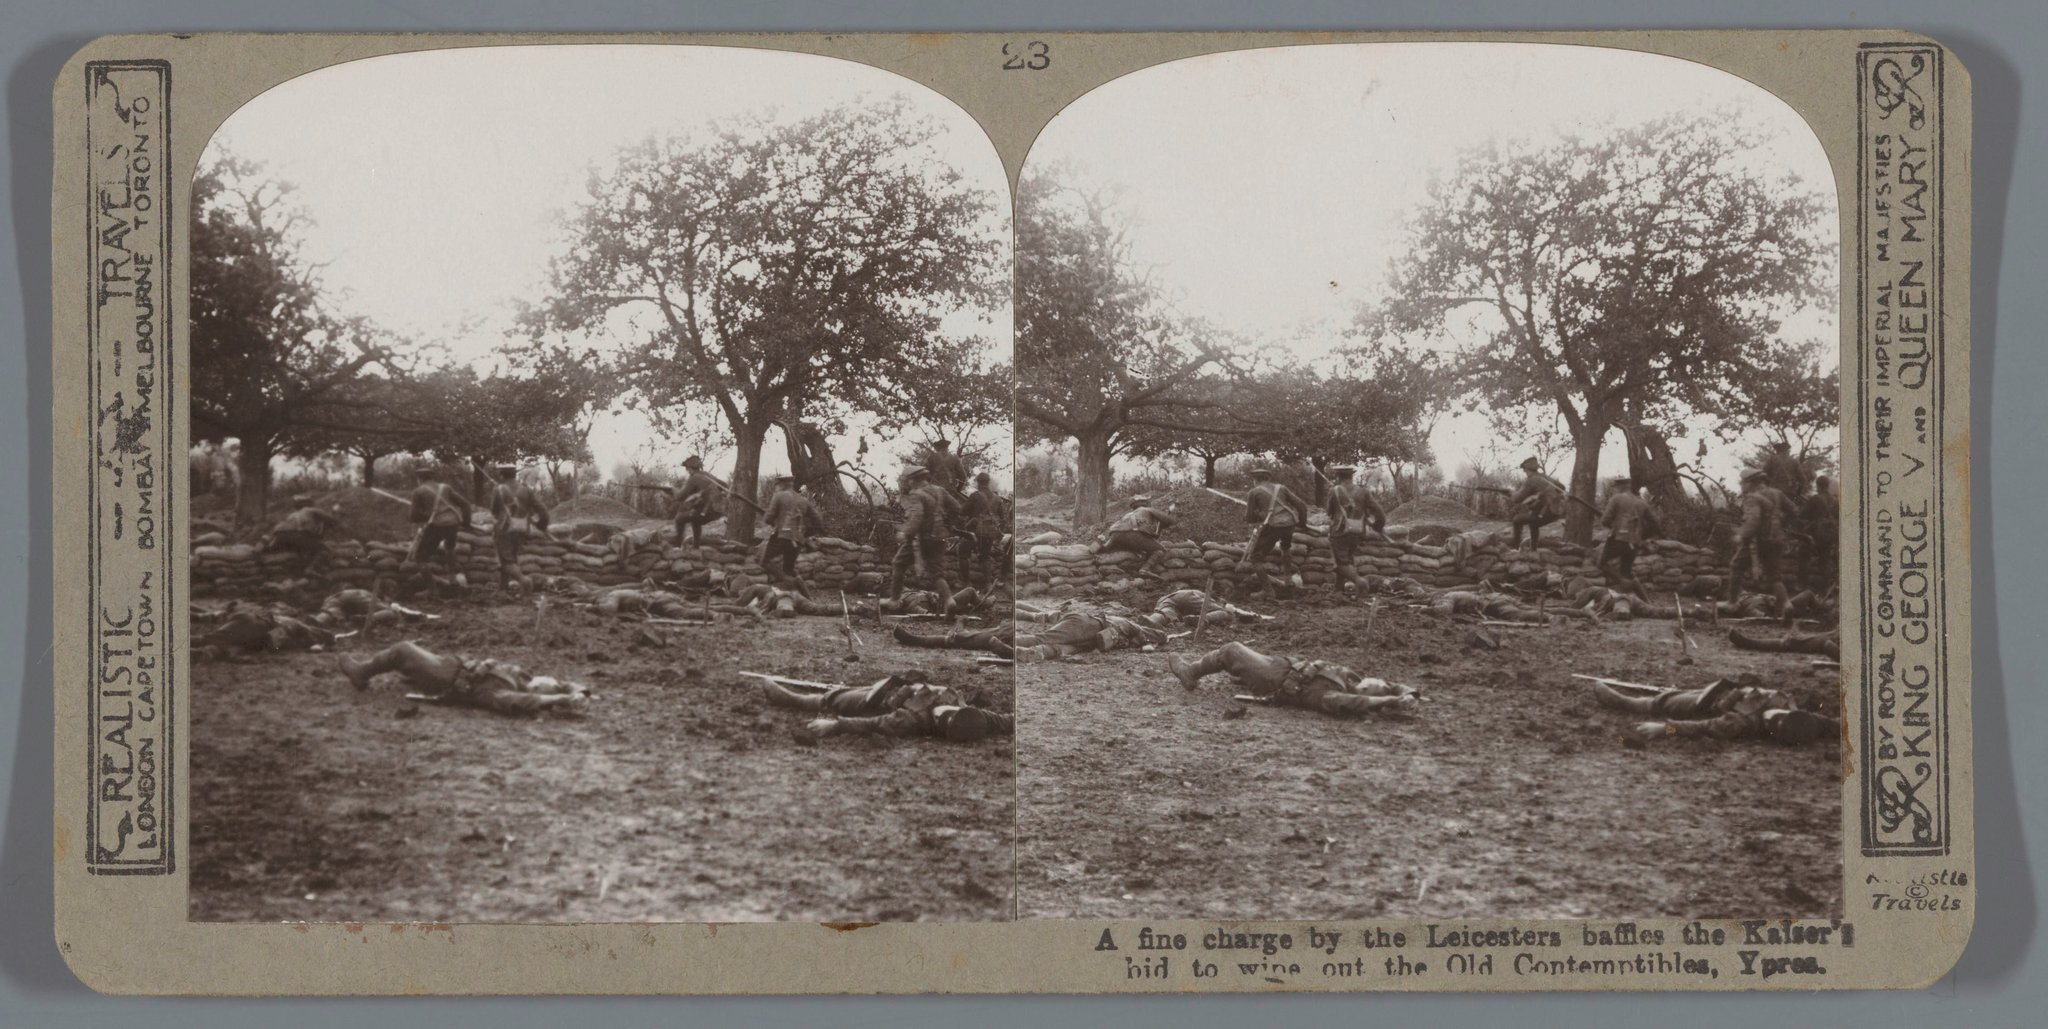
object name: stereograph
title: A fine charge by the Leicesters baffles the Kaiser's bid to wipe out the Old Contemptibles, Ypres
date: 1914-1918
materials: cardboard, photographic support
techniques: gelatin silver print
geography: ieper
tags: private soldier, charge ~ battle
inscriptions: number: ‘23’, inscription: ‘By Royal command to their Imperial majesties King George V and Queen Mary’